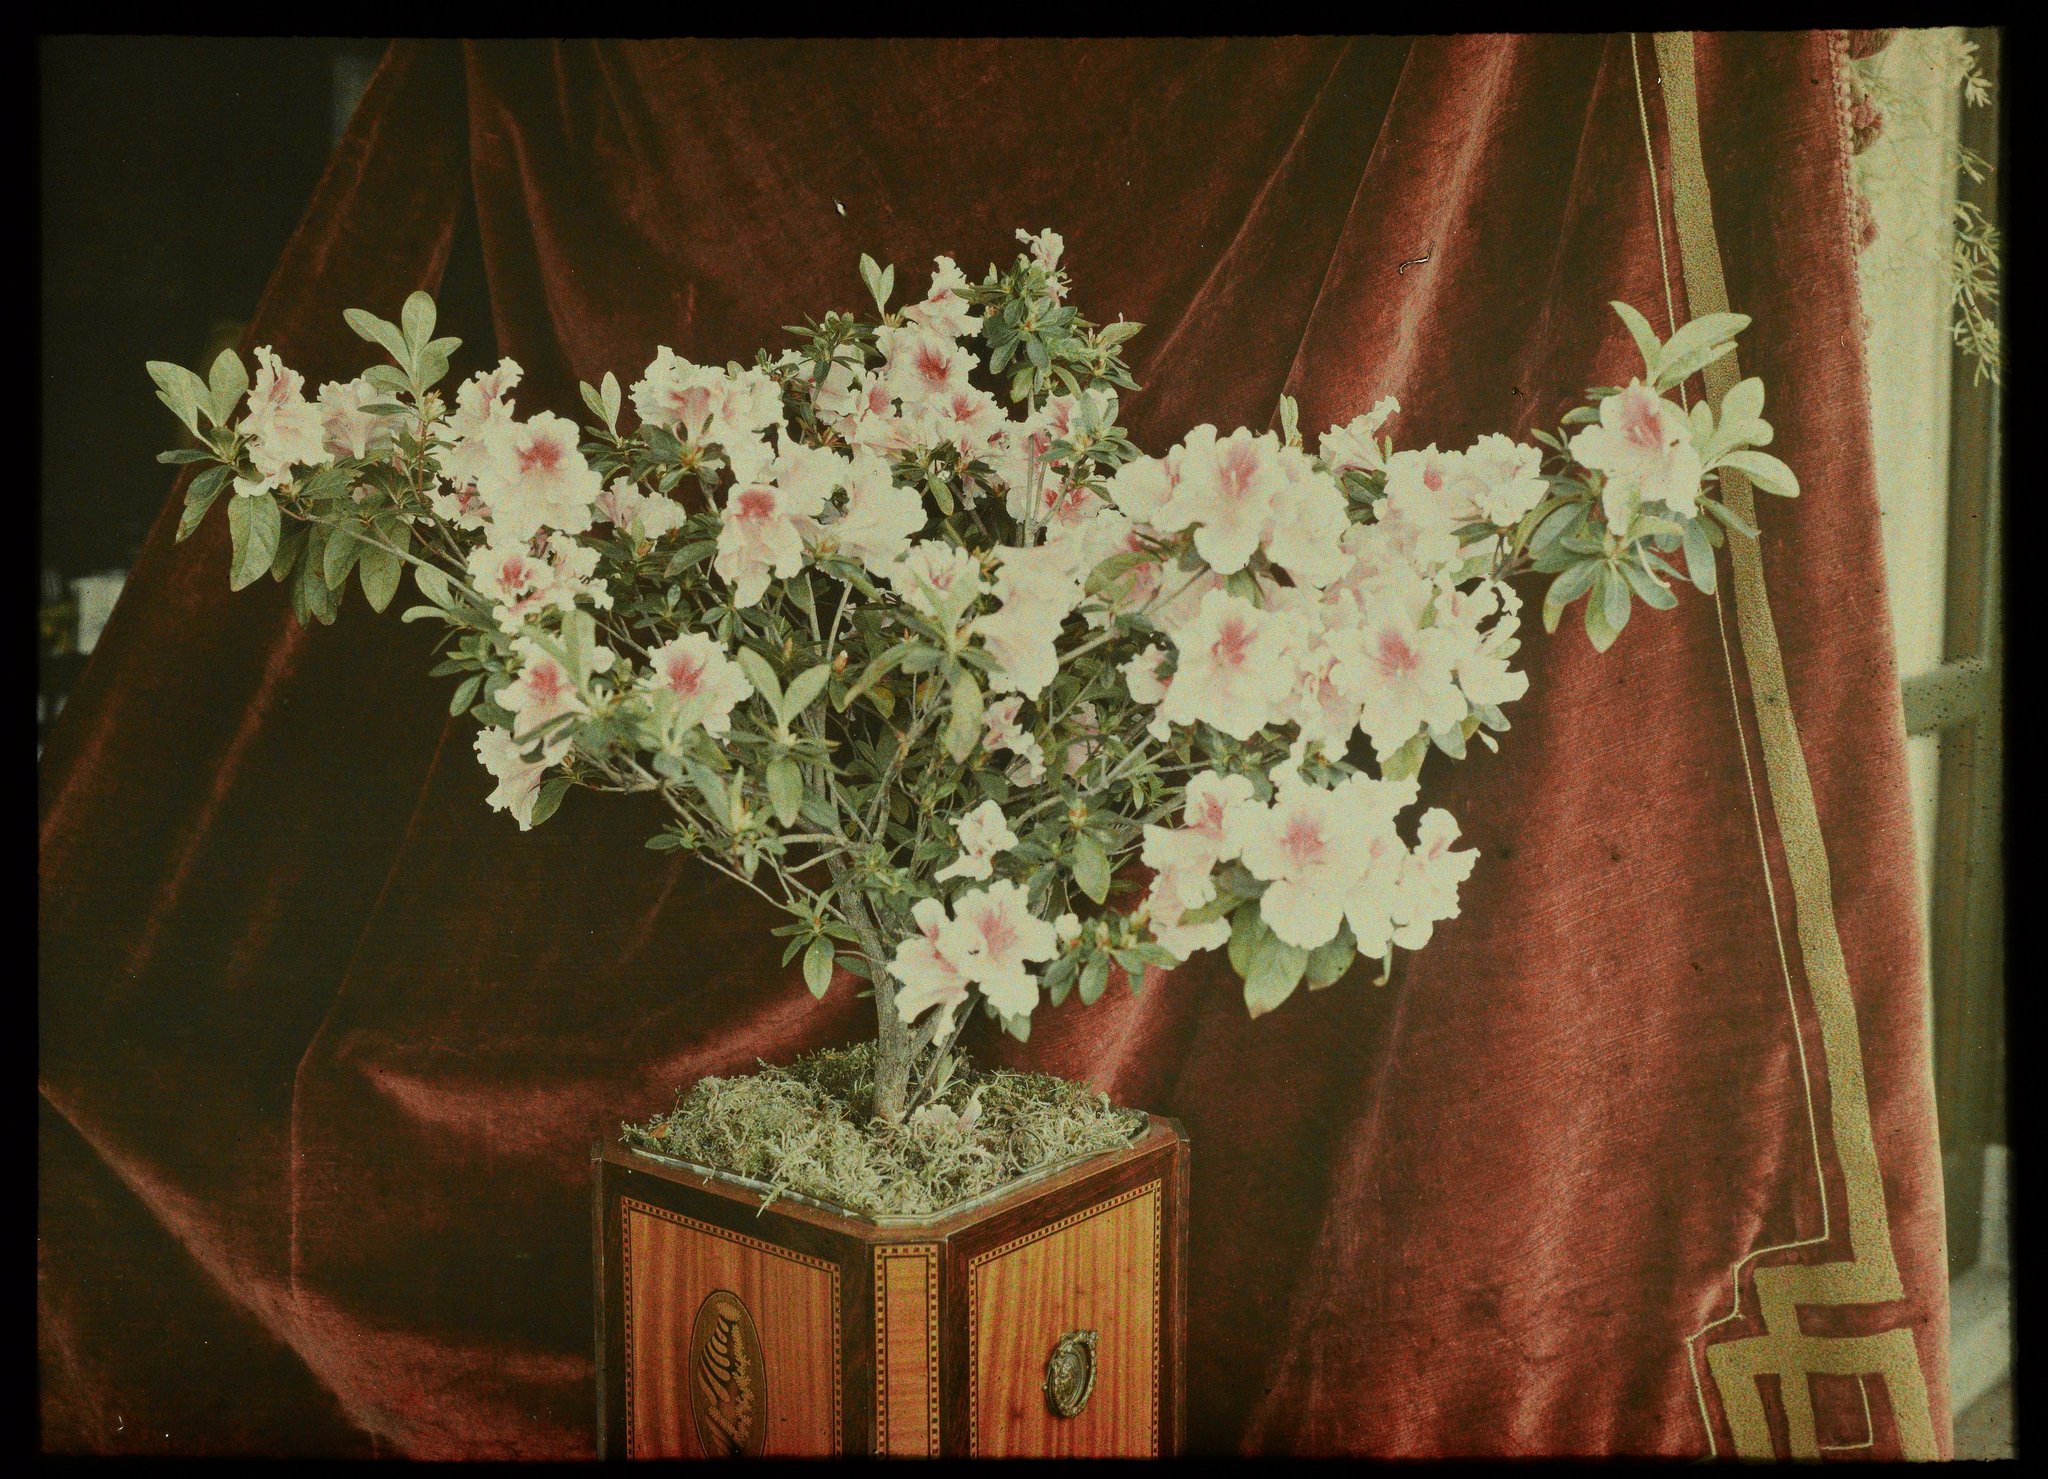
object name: glasdia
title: Bloeiende plant in een interieur, tegen de achtergrond van rood fluwelen stof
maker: adolphe burdet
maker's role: fotograaf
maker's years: 1860-1940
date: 1907-1930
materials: glass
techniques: autochrome process, slide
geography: netherlands